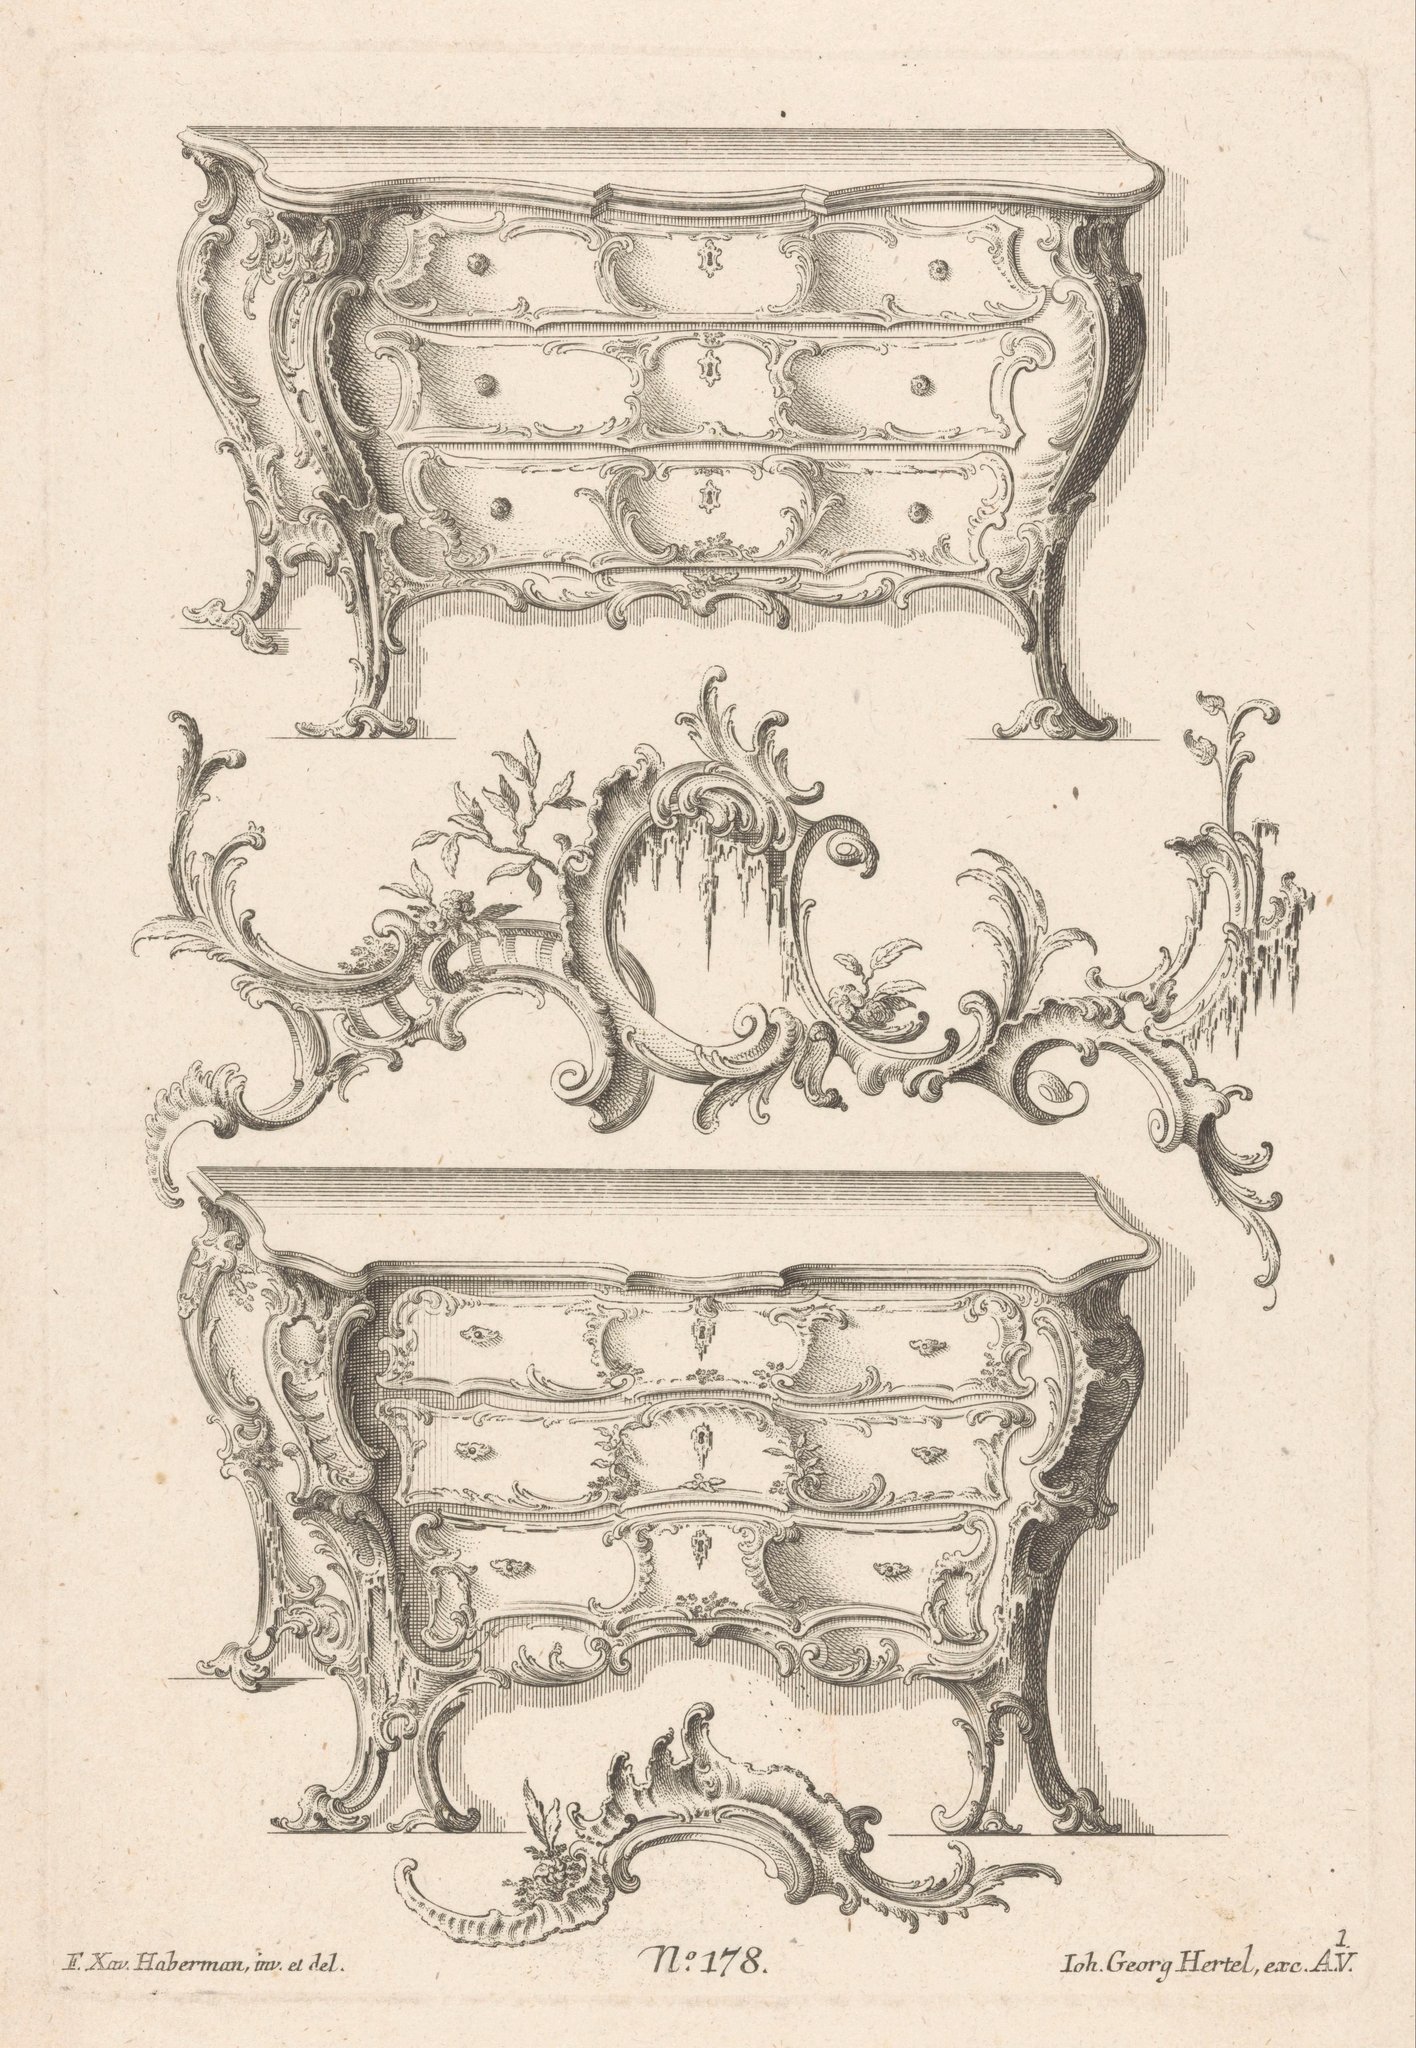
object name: ornament print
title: Commodes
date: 1731-1775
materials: paper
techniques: engraving, etching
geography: augsburg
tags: ornamental cupboard, rocaille ornament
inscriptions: collector's mark: Lugt 2228, collector's mark: Lugt 2760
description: Twee commodes met drie lades, met rocaille ornamenten. Uitgeversnummer 178.